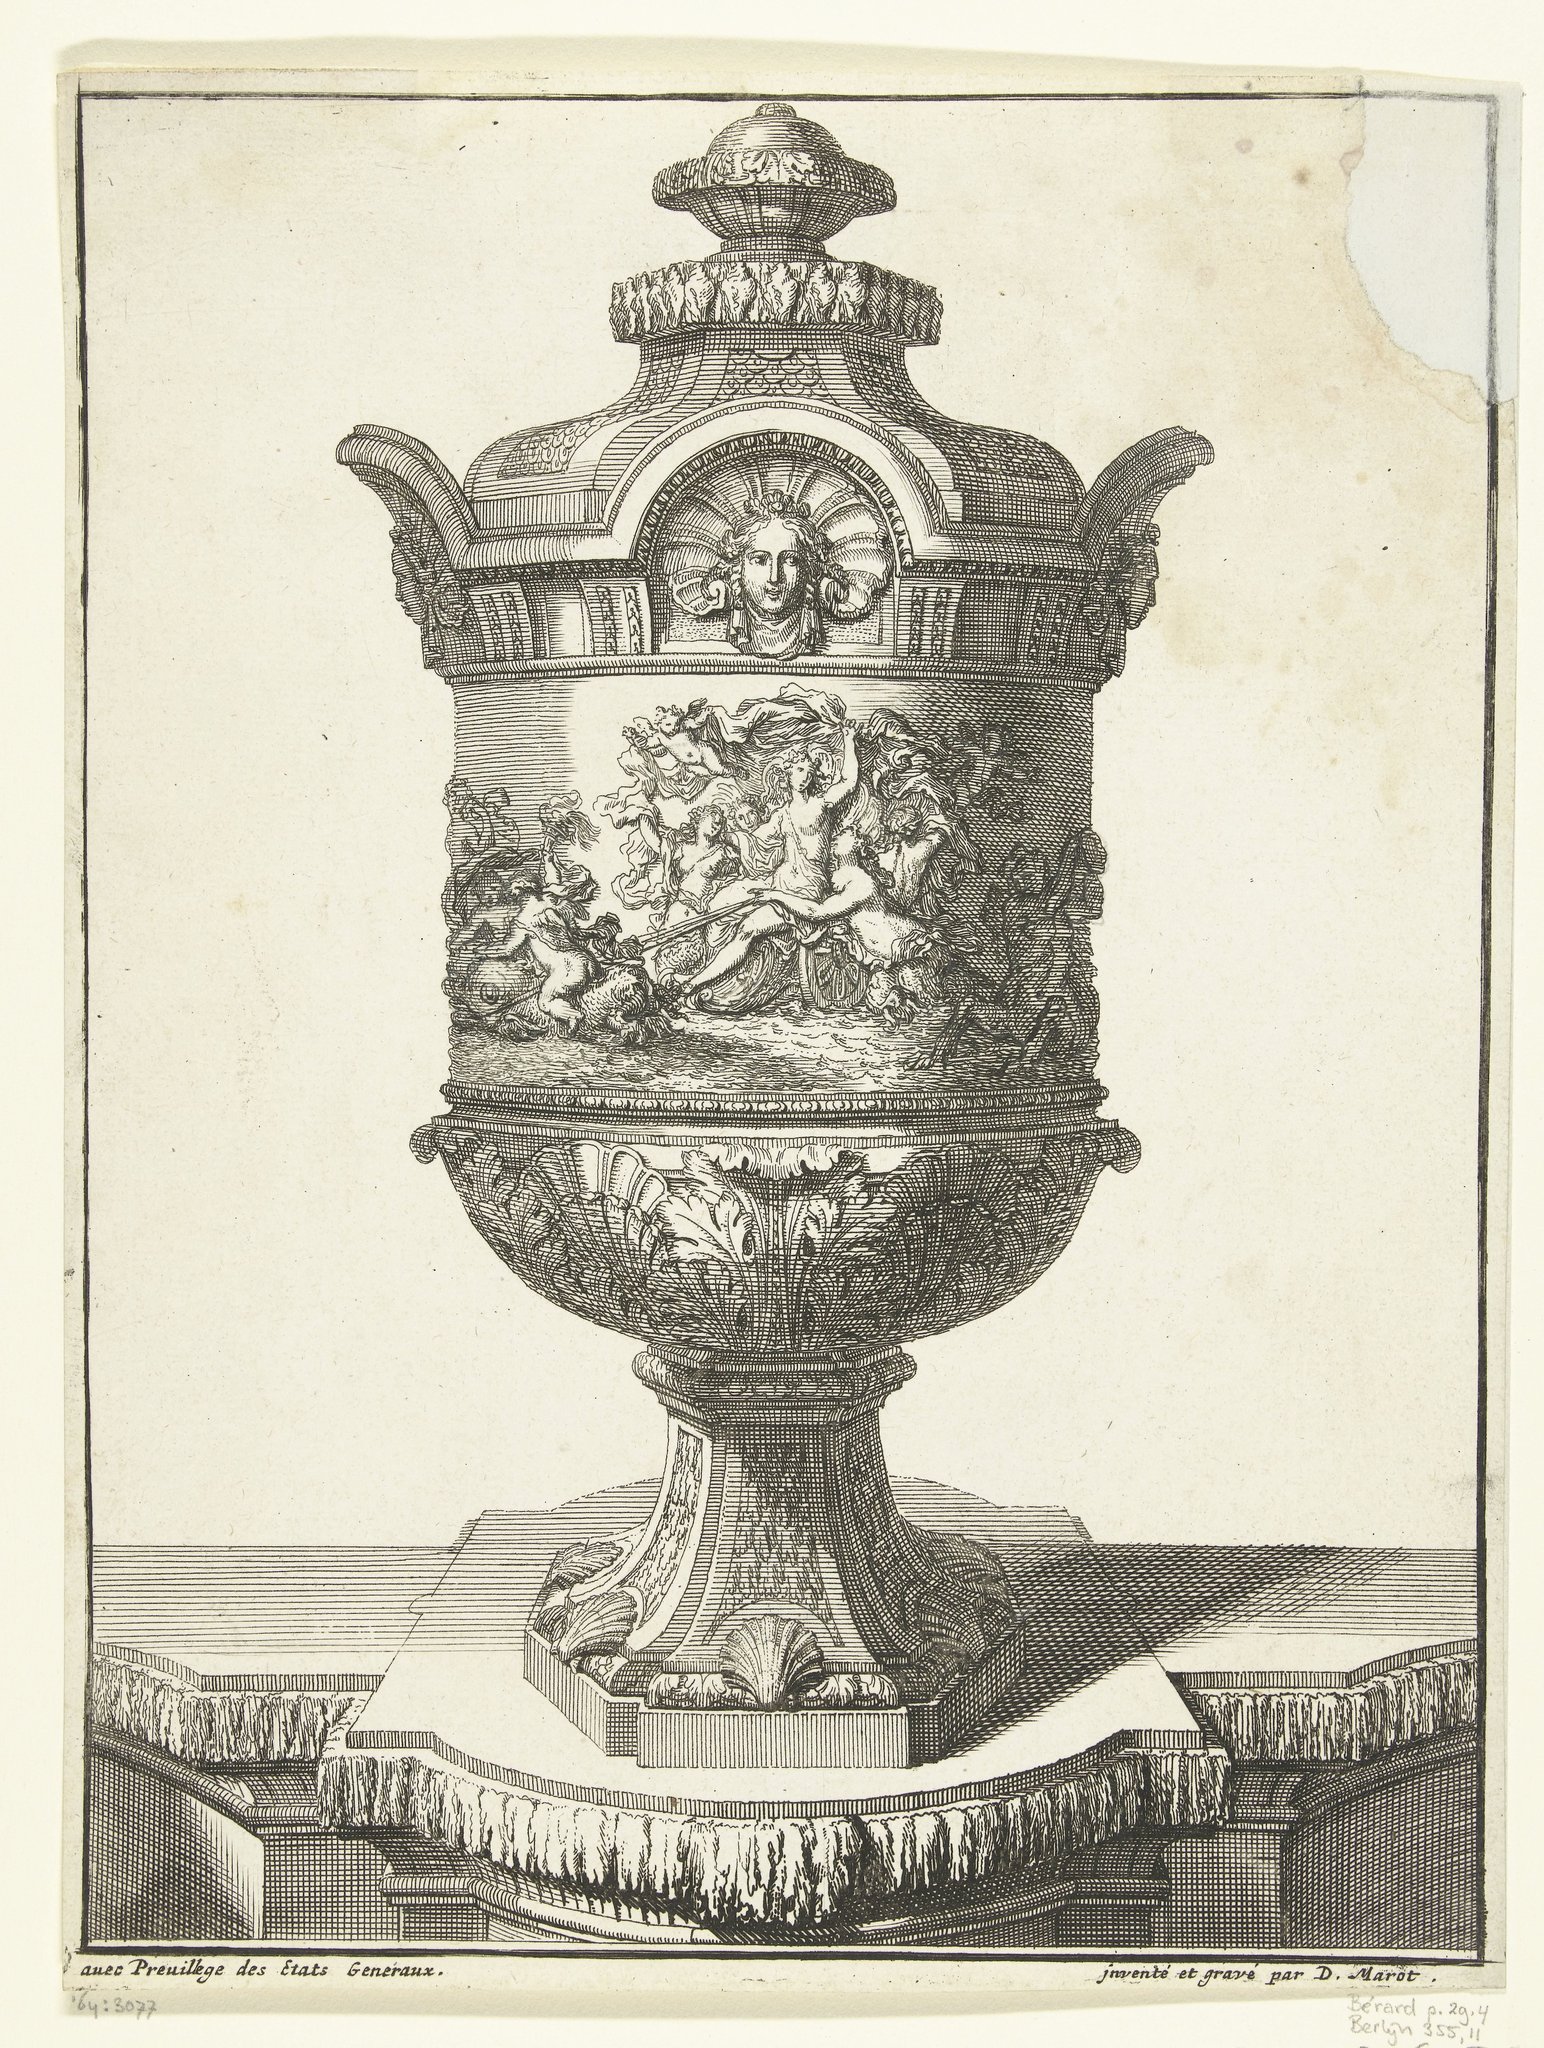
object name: ornament print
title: Vasses de la Maison Royalle de L'oo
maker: daniël marot (i)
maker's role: draughtsman, print maker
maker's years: 1661-1752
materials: paper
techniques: etching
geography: netherlands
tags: triumph of amphitrite, garden vase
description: Vaas op een achthoekige voet met bas-reliëf met een personificatie van Groot-Brittanië. De handvatten worden ondersteund door vrouwelijke termen. Het deksel is gedecoreerd met fleur-de-lis en bekroond met een Engelse kroon. Blad uit serie van 6 bladen met tuinvazen van Paleis Het Loo.